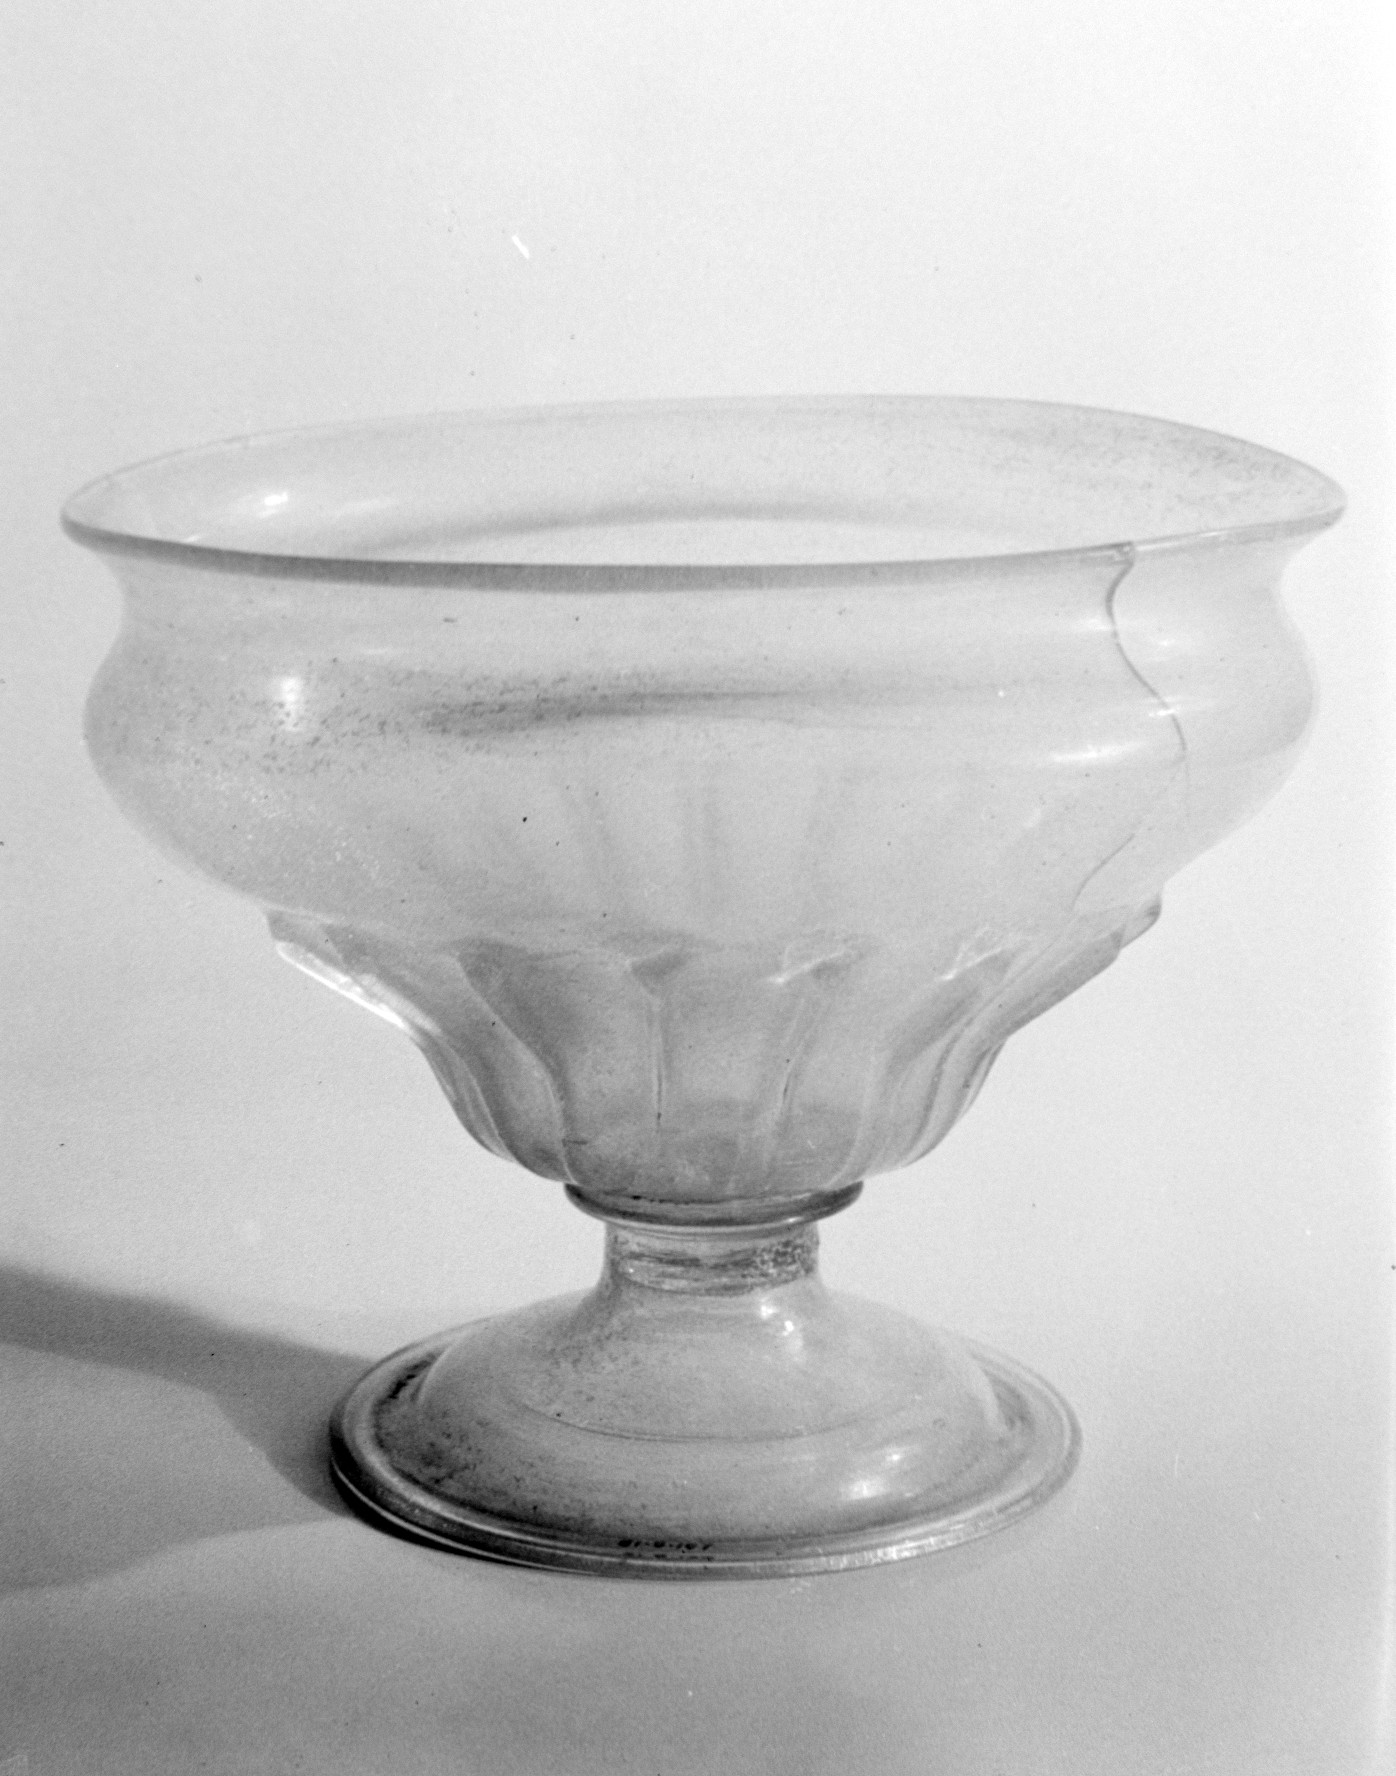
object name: bowl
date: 1701-1800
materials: glass